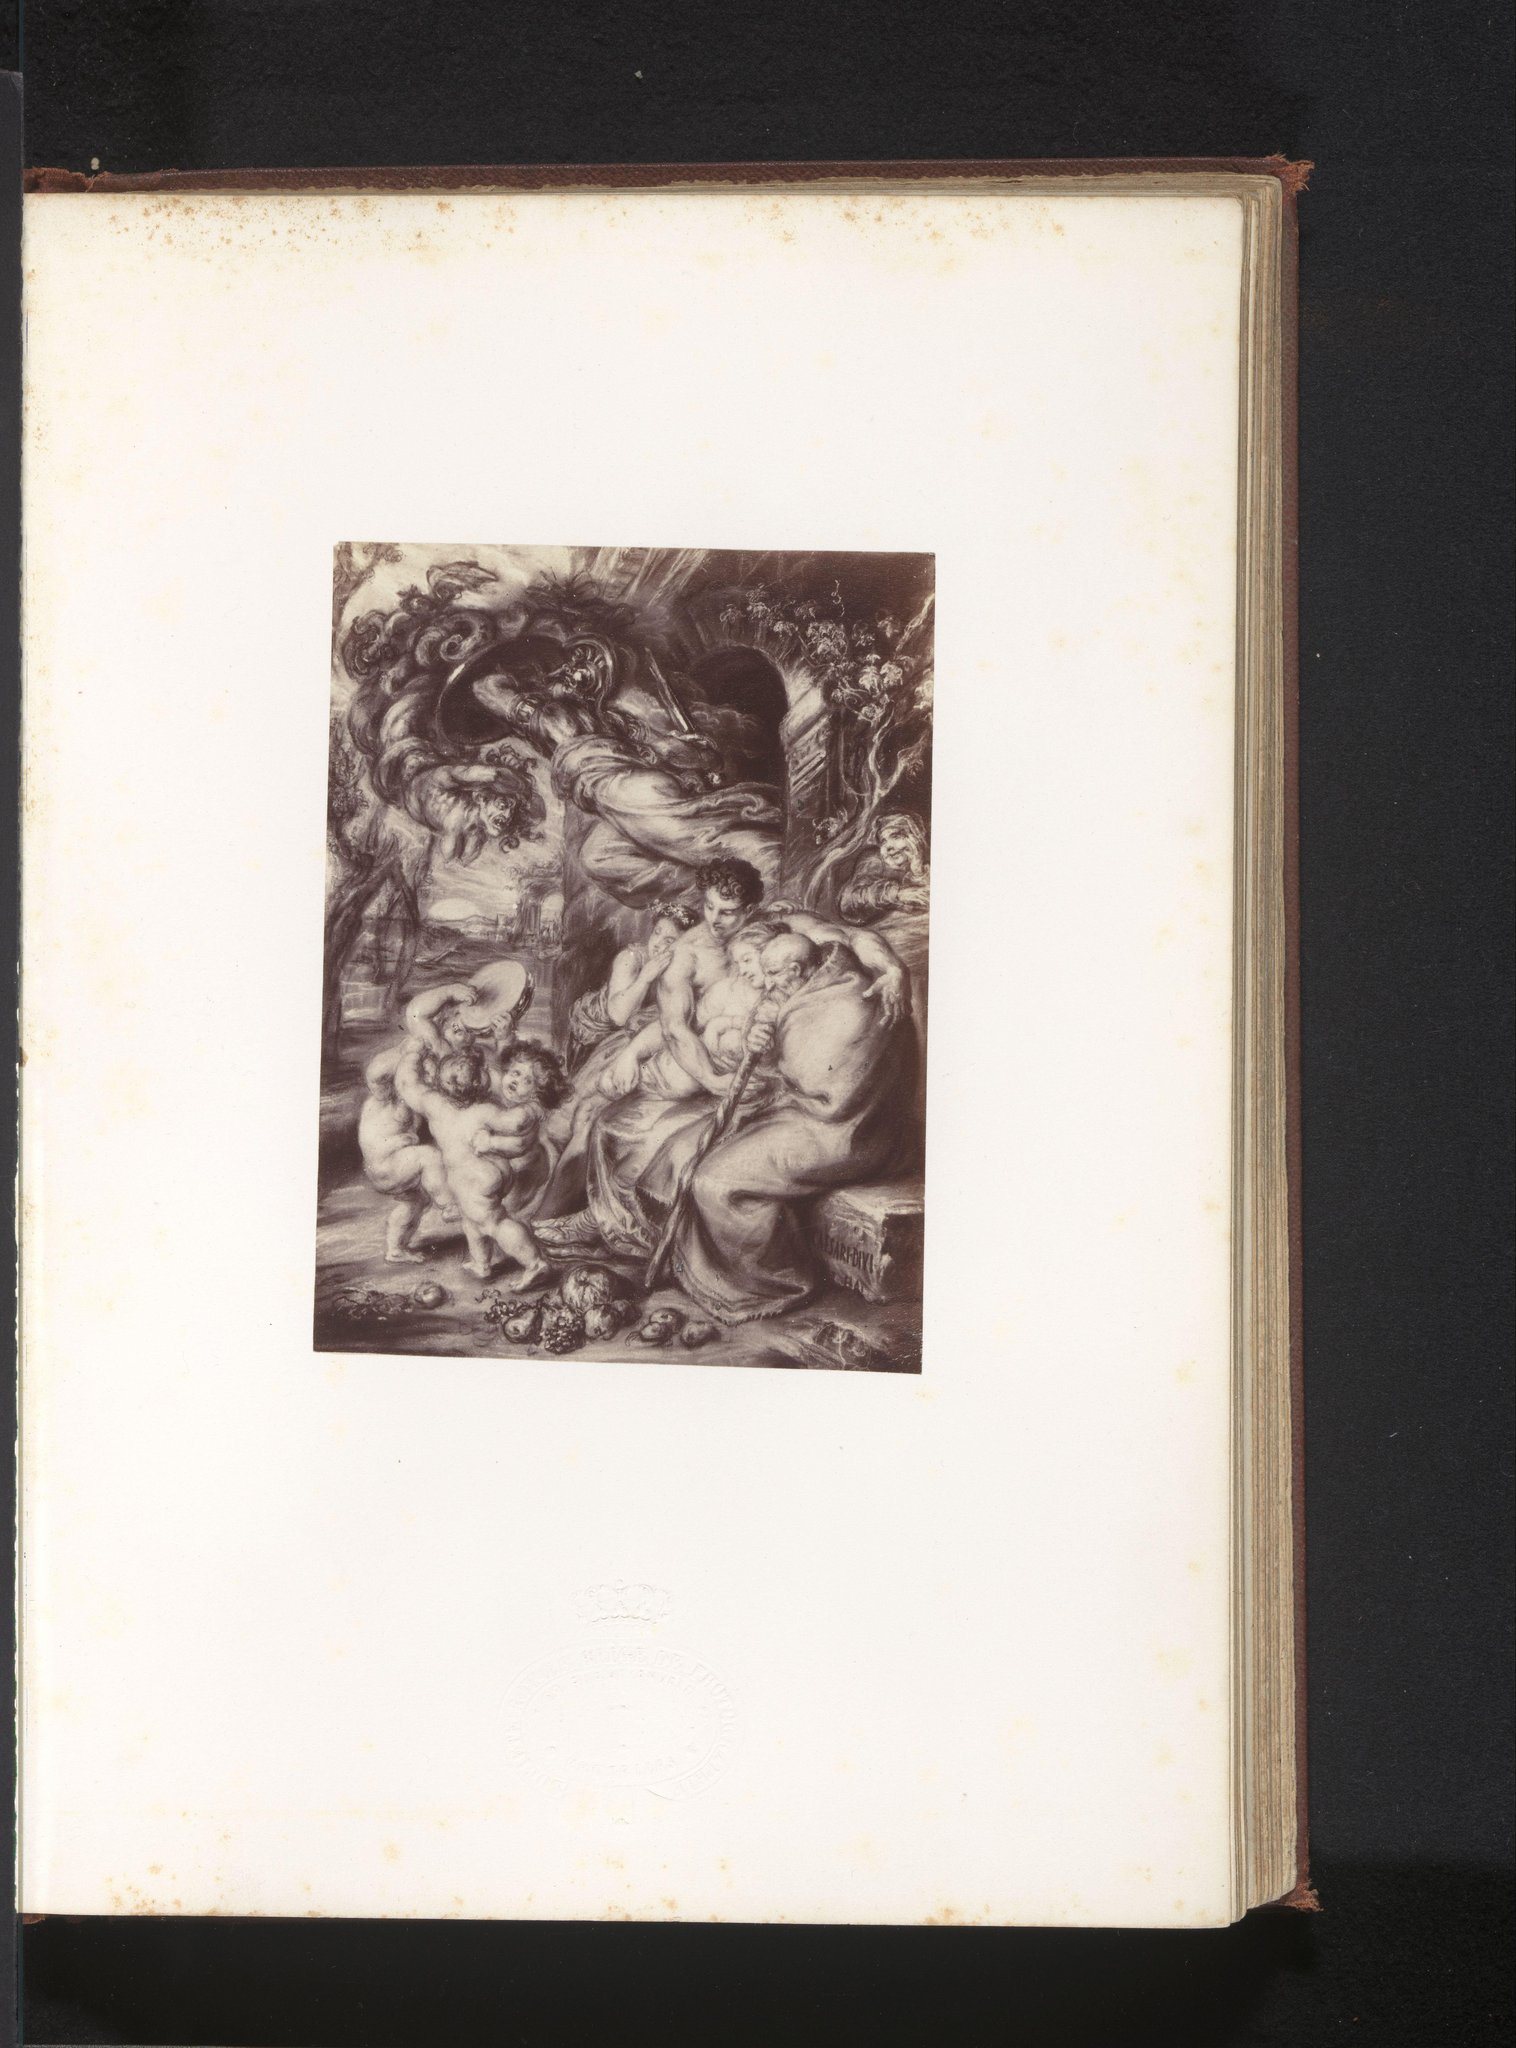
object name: page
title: Fotoreproductie van In familie I: De familie door Antoine Wiertz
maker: edmond fierlants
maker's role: fotograaf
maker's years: 1819-1869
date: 1863-1868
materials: photographic support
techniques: albumen print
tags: family life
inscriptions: check stamp: ‘SOCIÉTÉ ROYALE BELGE DE PHOTOGRAPHIE/ 69, RUE KEYENVELD/ BRUXELLES’